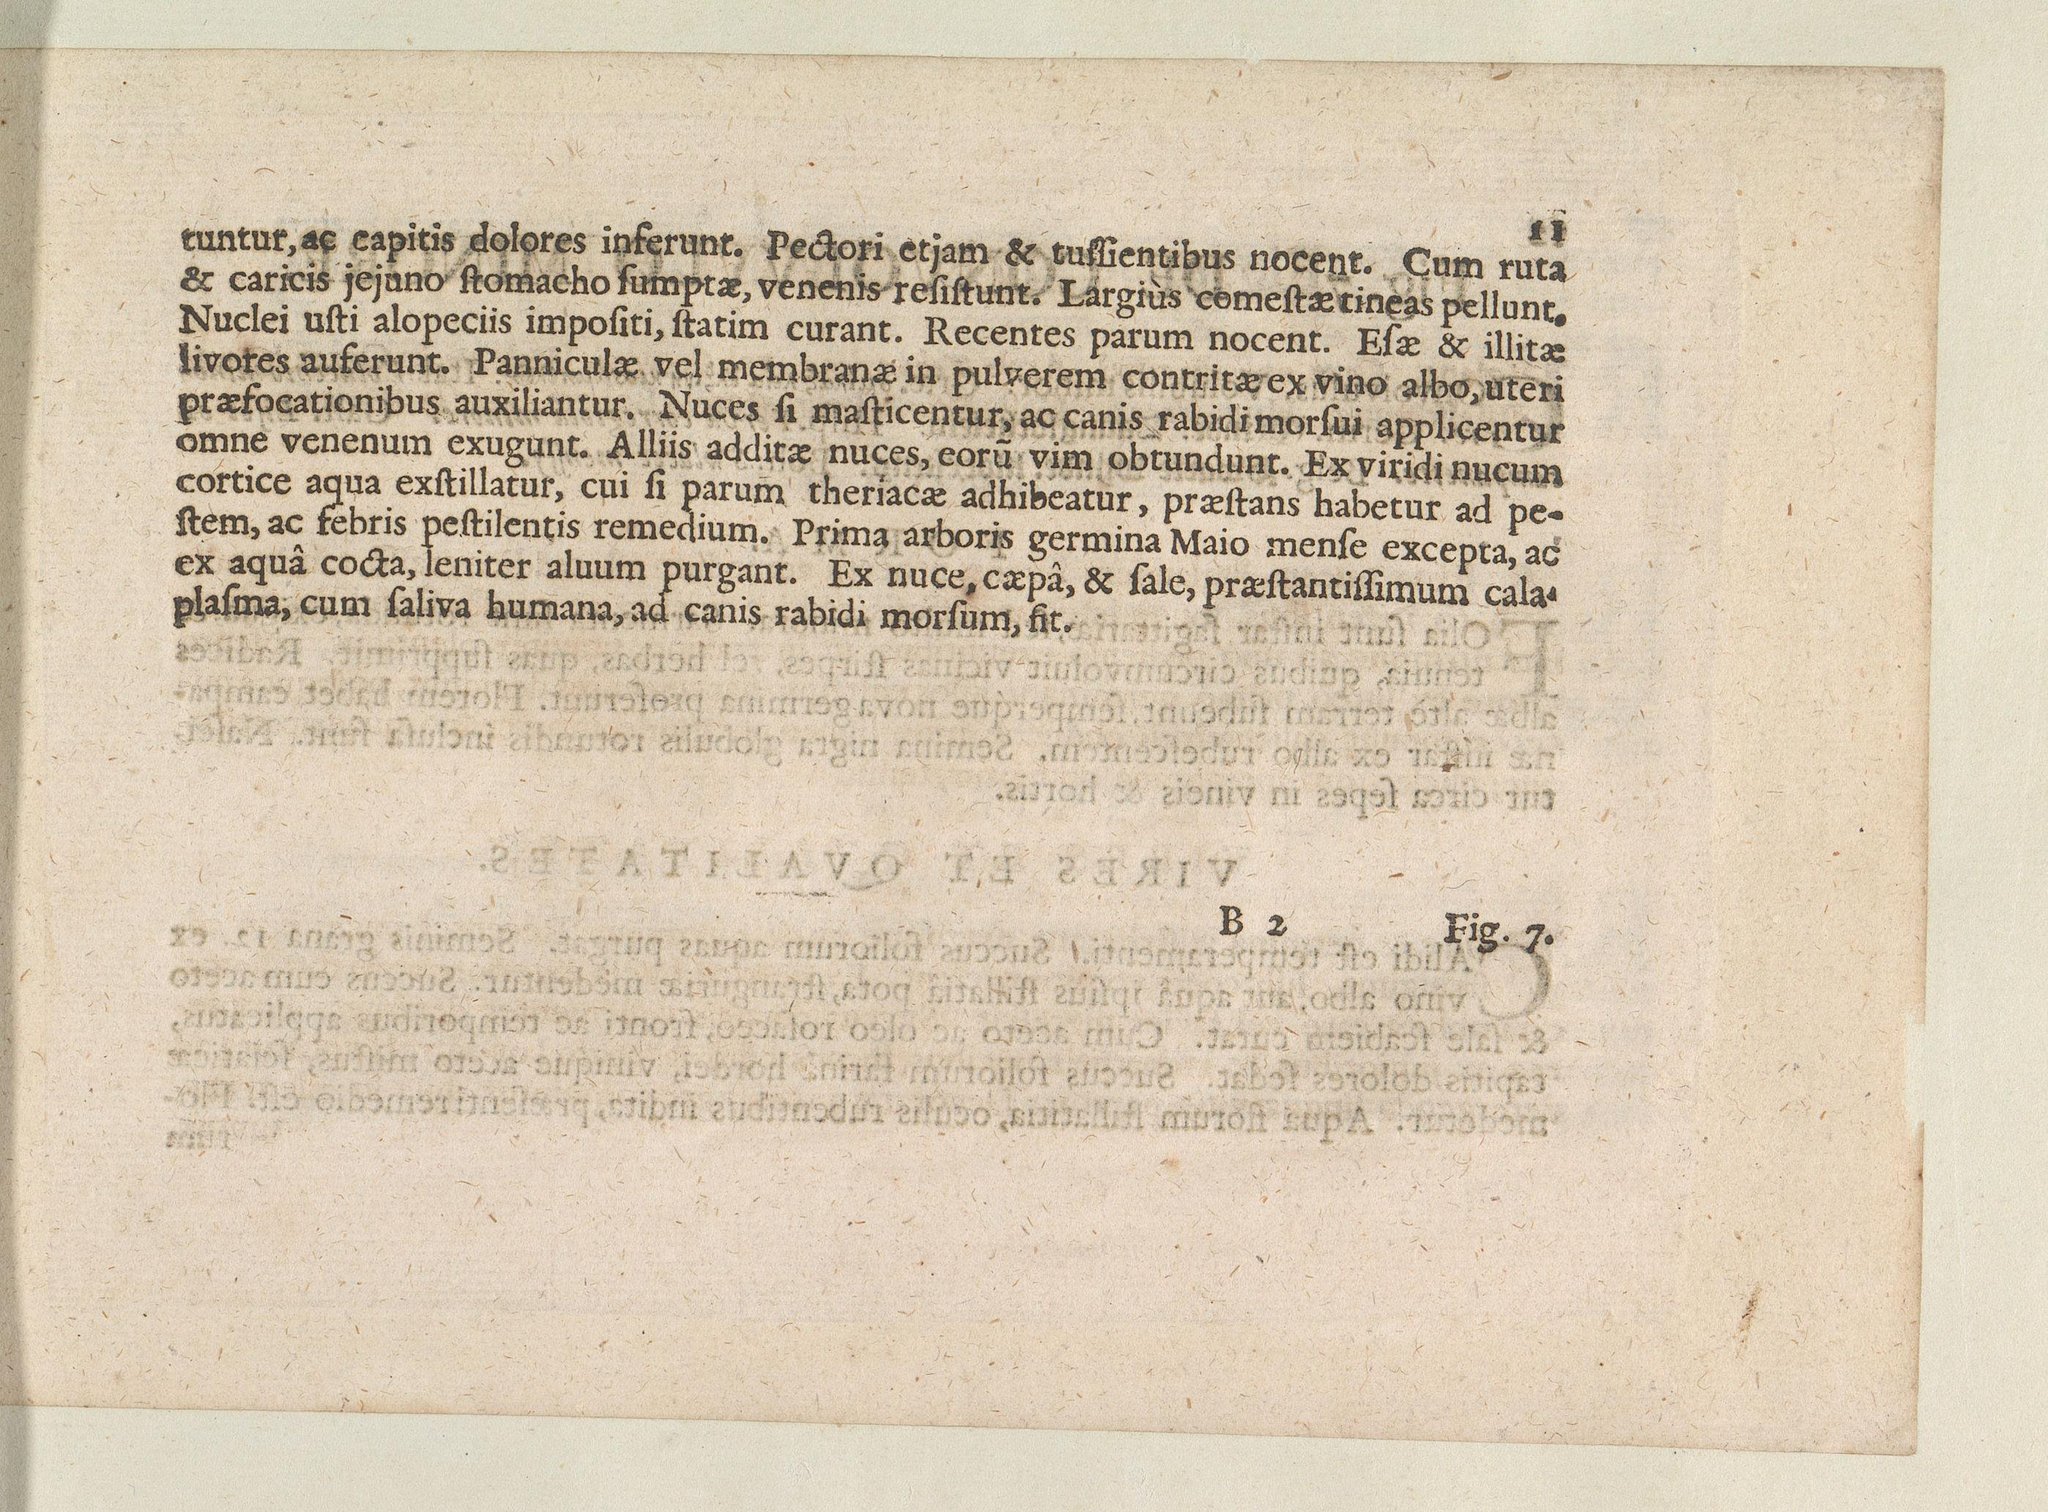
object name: text sheet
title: Fig. 6 'De Ivglande' in De Boodts herbarium van 1640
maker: anselmus boëtius de boodt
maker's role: draughtsman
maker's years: 1550-1632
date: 1640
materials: ink, paper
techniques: letterpress printing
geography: bruges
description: Beschrijving bij Fig. 6 op p. 11 in: Anselmi Boëtii de Boot I.C. Brugensis & Rodolphi II. Imp. Roman. medici a cubiculis Florum, Herbarum, ac fructuum selectiorum icones, & vires pleraeque hactenus ignotæ. Onderdeel van het album met bladen en platen uit De Boodts herbarium van 1640. Het twaalfde van twaalf albums met aquarellen van dieren, vogels en planten bekend rond 1600, gemaakt in opdracht van keizer Rudolf II.